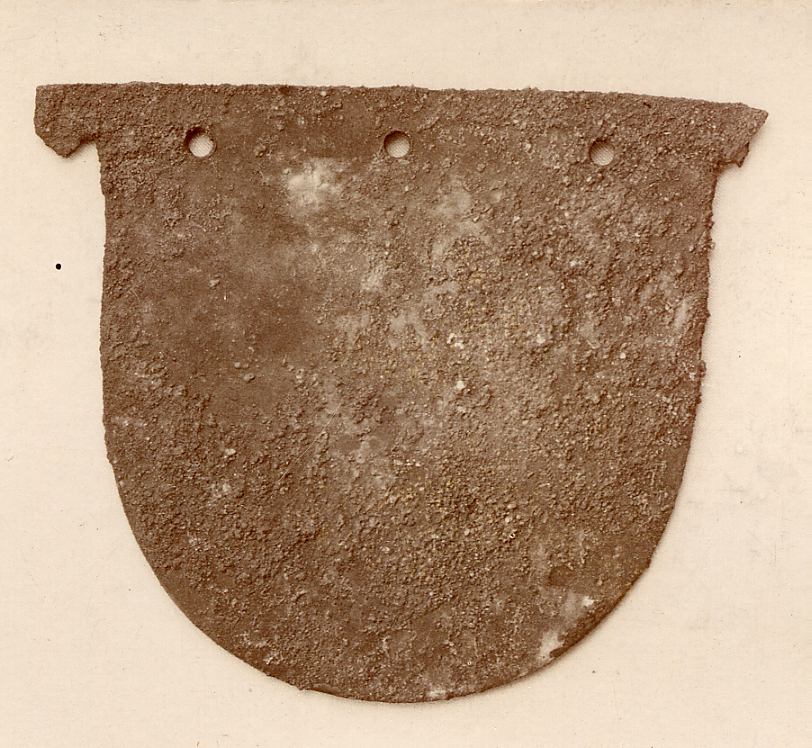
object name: ax head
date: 2100-1950 BCE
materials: bronze, copper alloy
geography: egypt